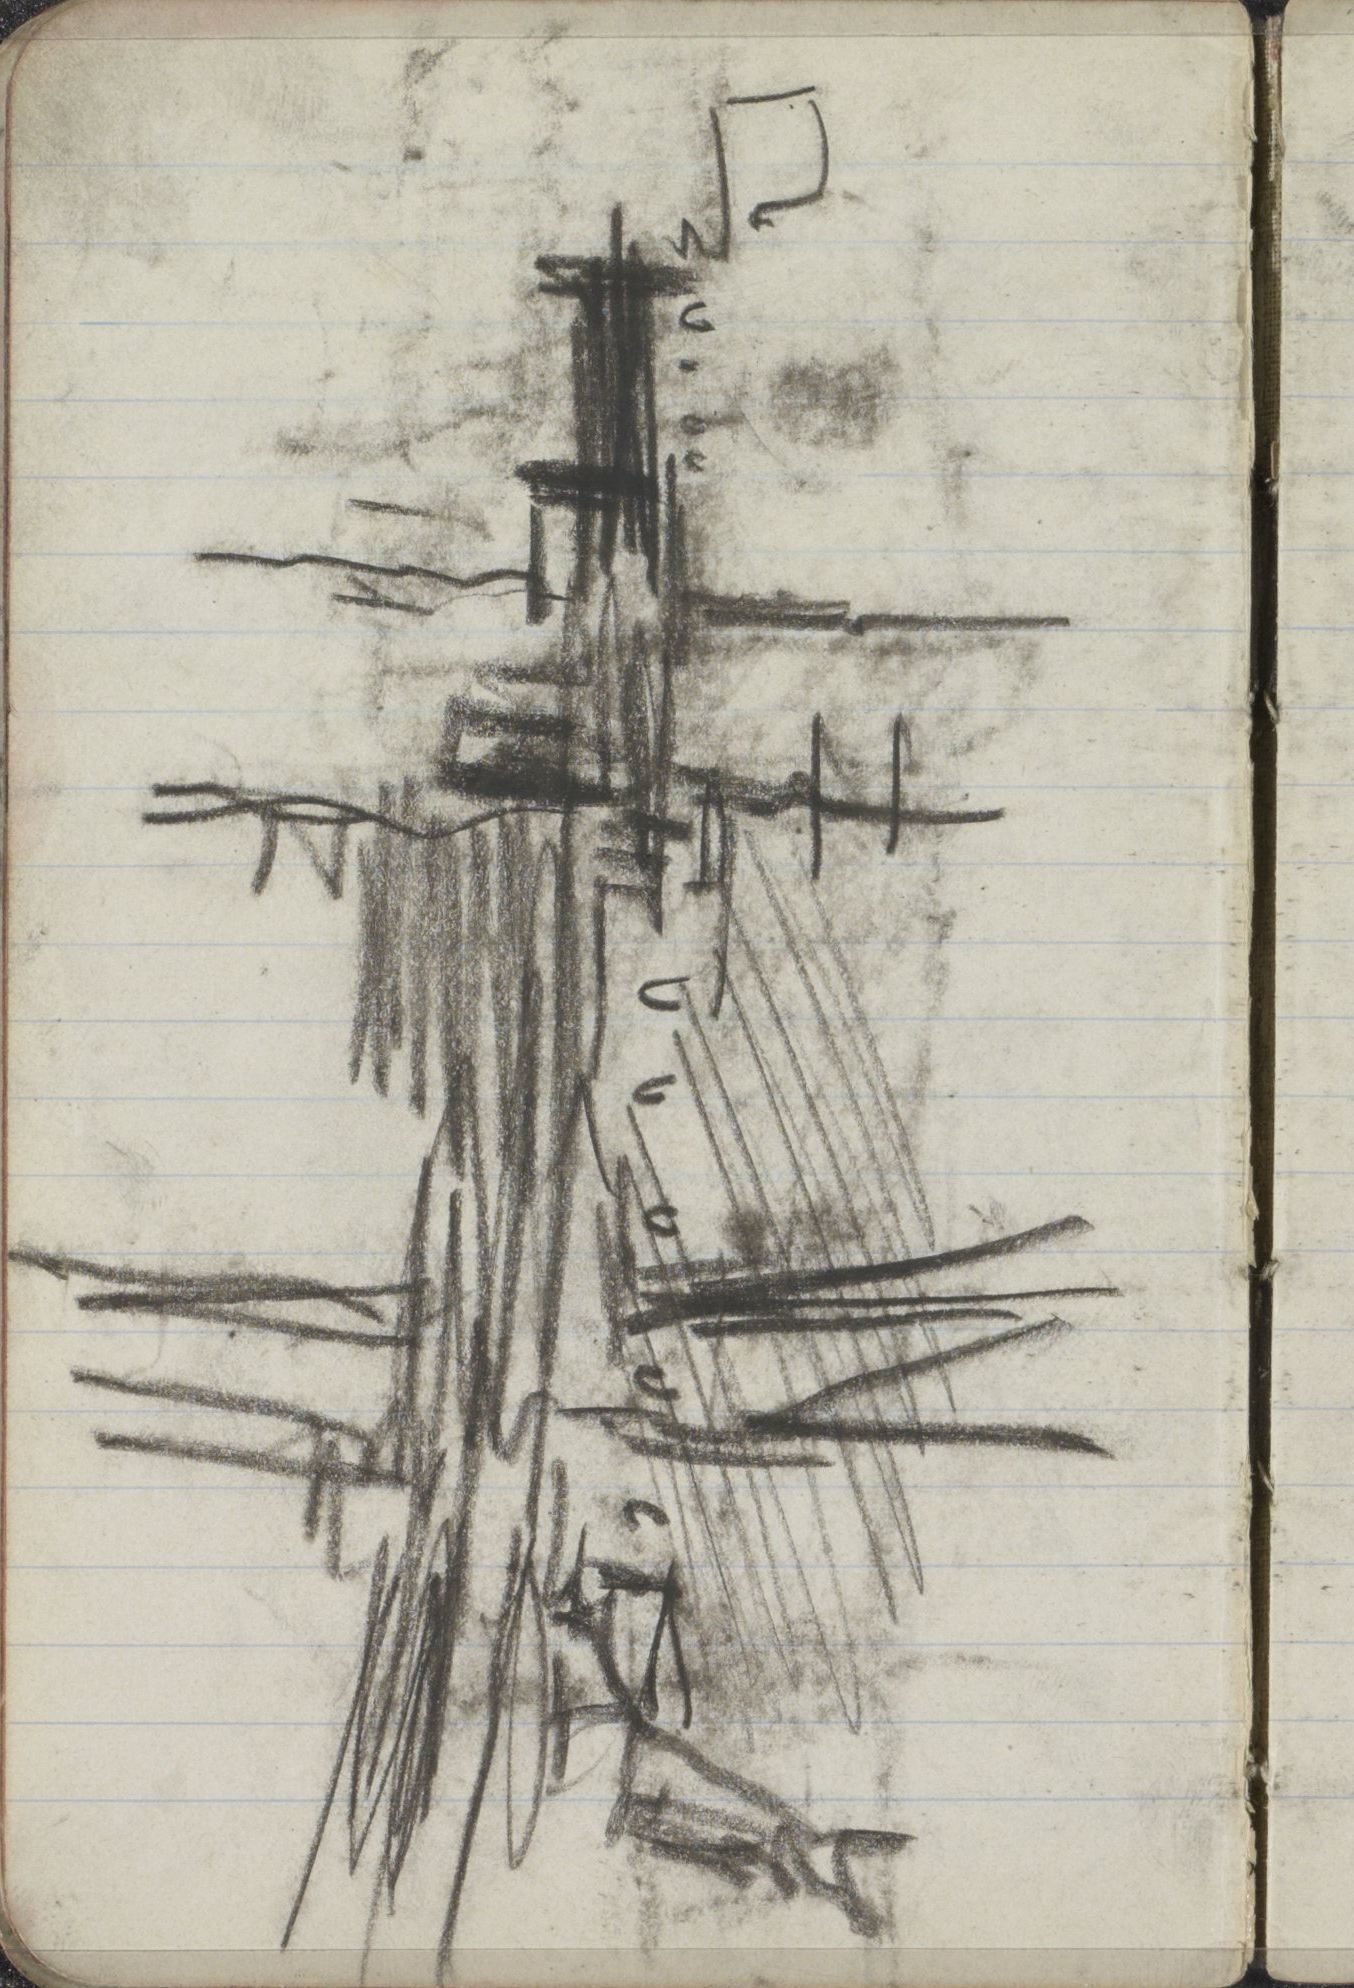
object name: sketchbook leaf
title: Gezicht in Amsterdam met boten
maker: george hendrik breitner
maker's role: draughtsman, painter, print maker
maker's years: 1857-1923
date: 1893-1898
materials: chalk, paper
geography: amsterdam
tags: ships (in general), canals, waters (in city) (+ city(-scape) with figures, staffage), amsterdam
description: Pagina 53 uit een schetsboek met 38 bladen.